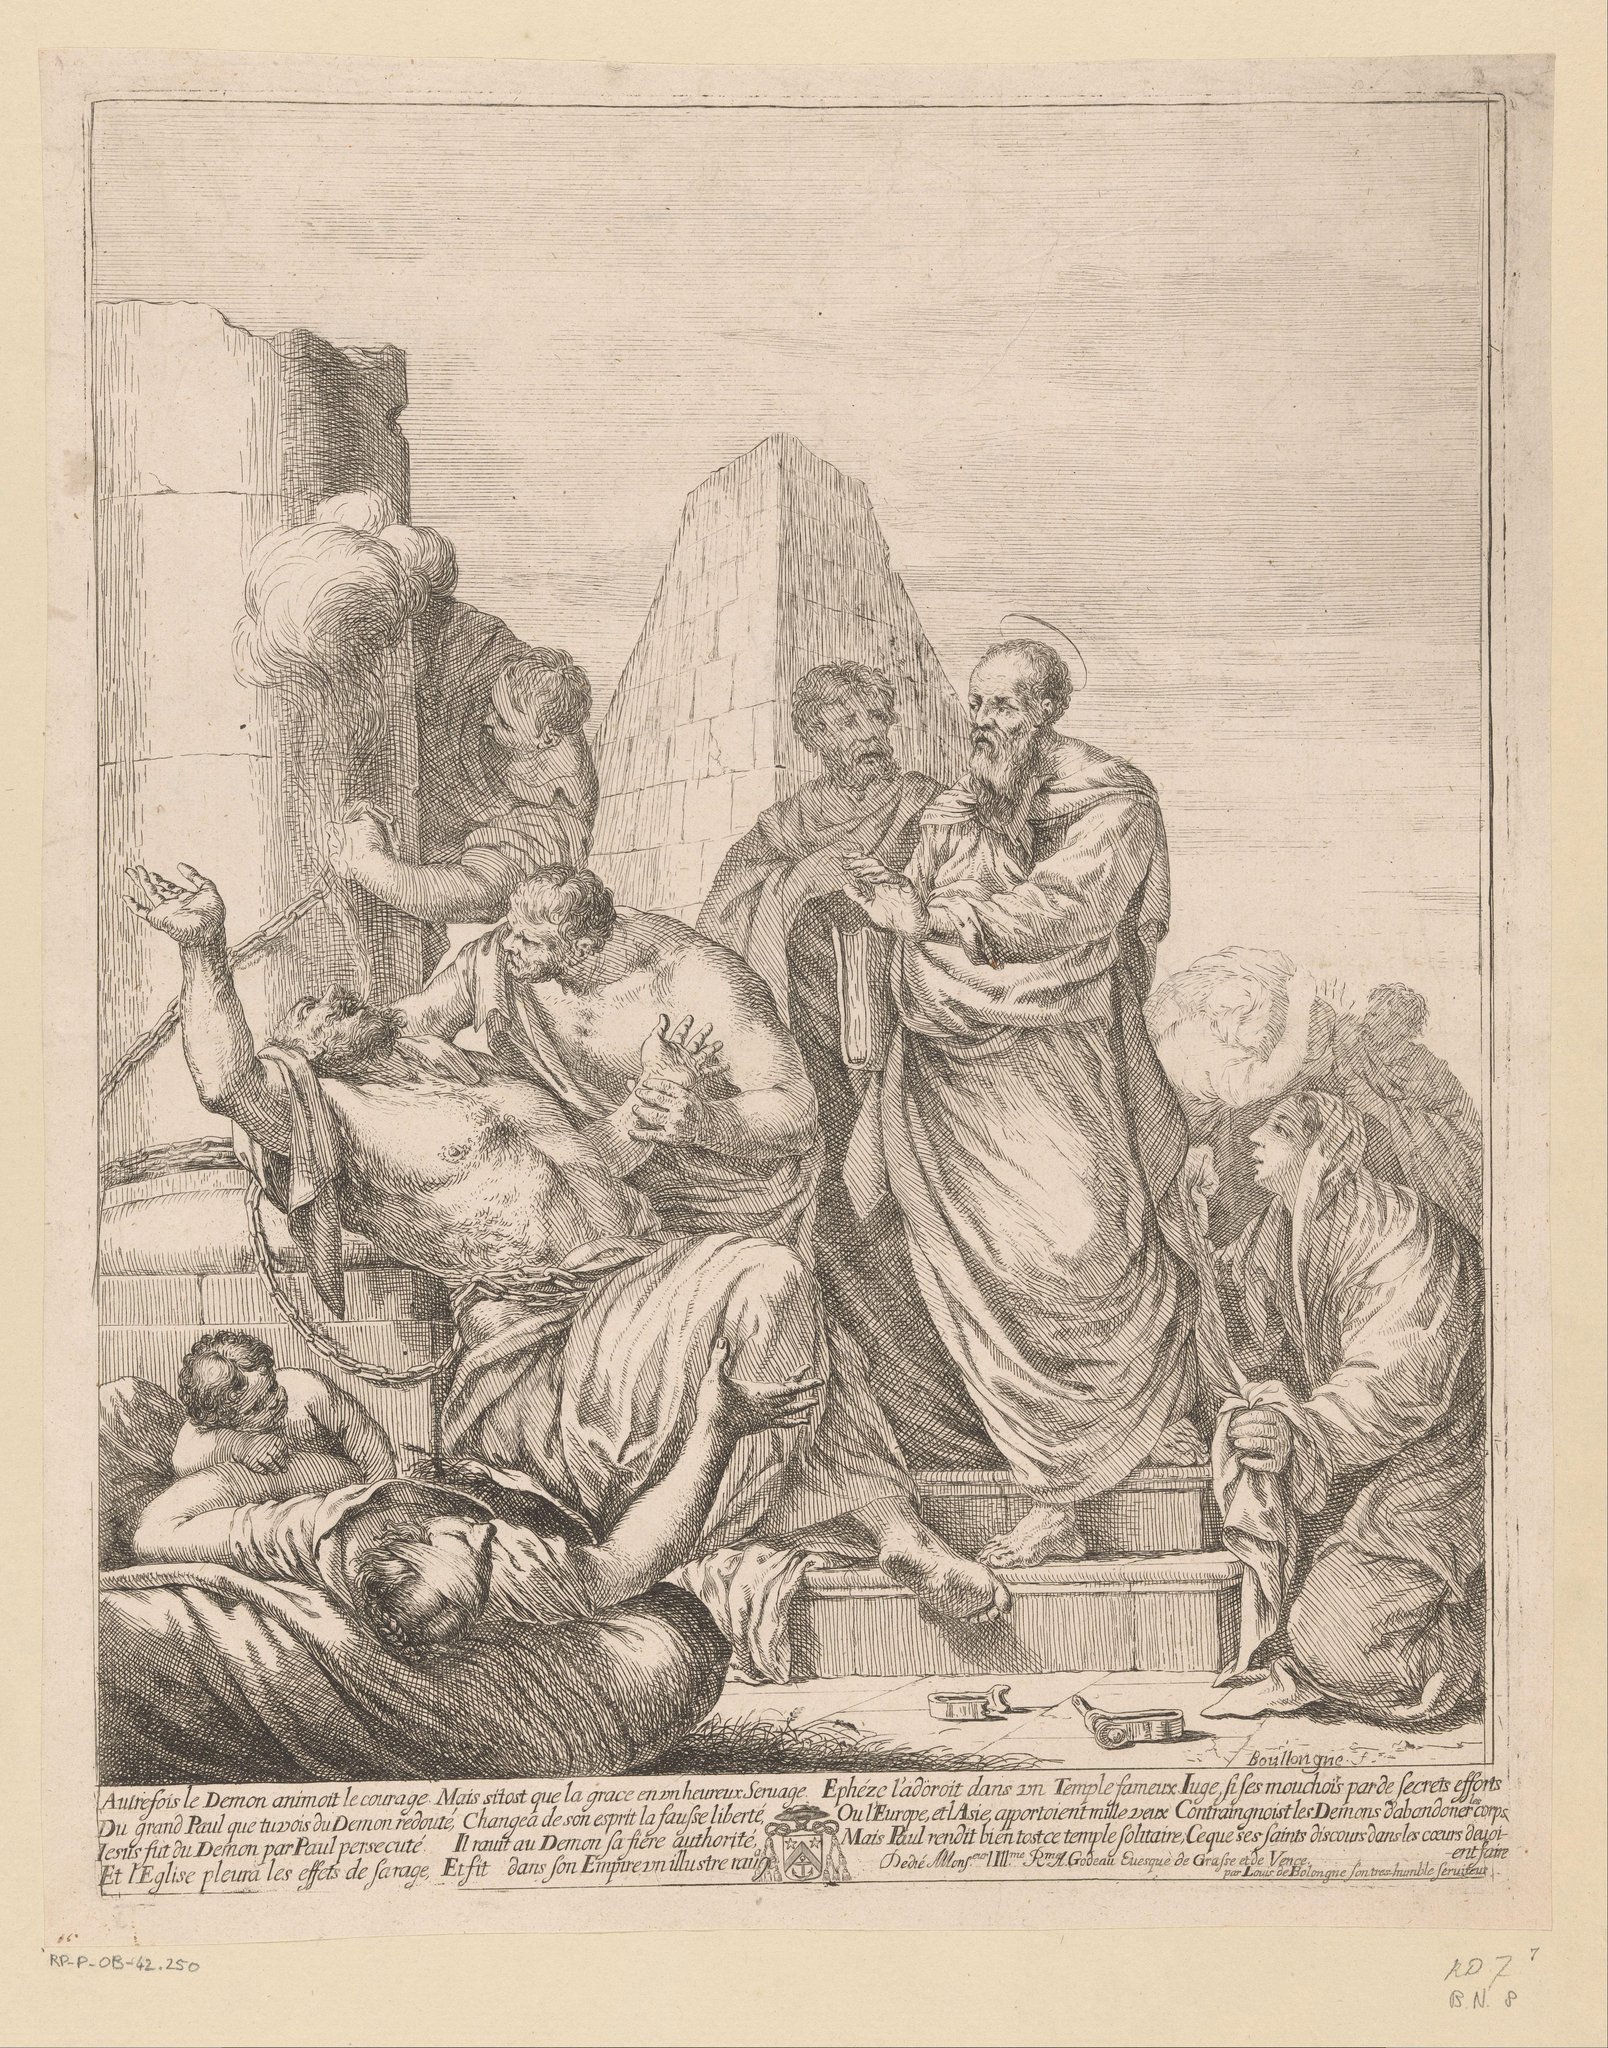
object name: print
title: Paulus in Efese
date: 1619-1674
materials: paper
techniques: etching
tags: the third missionary journey of paul: the stay in ephesus (acts 19)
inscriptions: collector's mark: Lugt 240